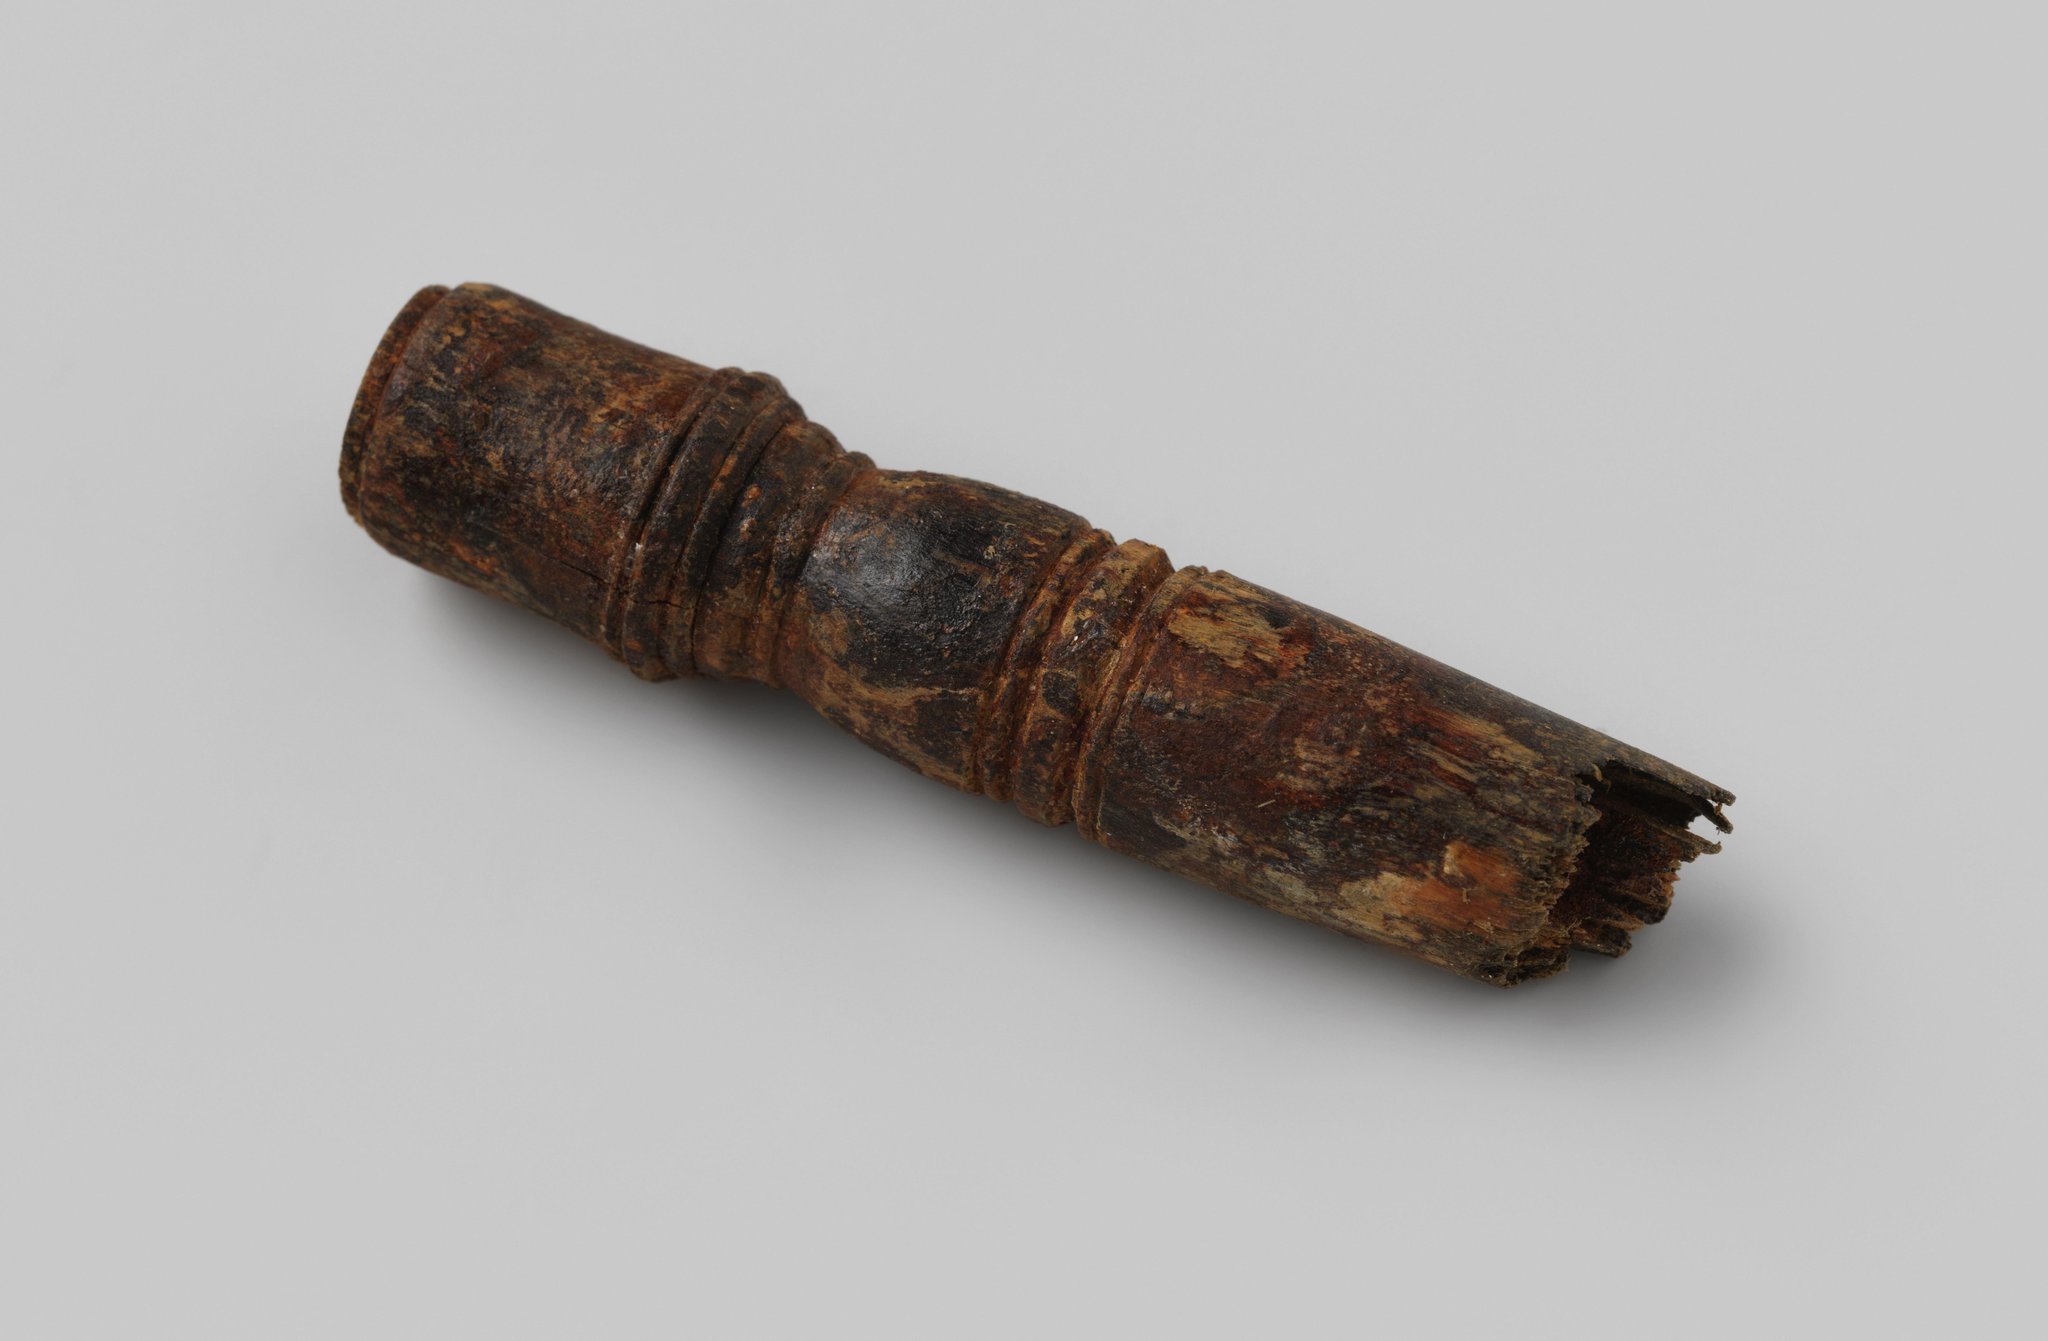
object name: helve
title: Houten steel uit het wrak van de Oost-Indiëvaarder Hollandia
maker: Anonymous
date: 1700-1743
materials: wood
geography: netherlands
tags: verenigde oostindische compagnie, hollandia (schip), annet